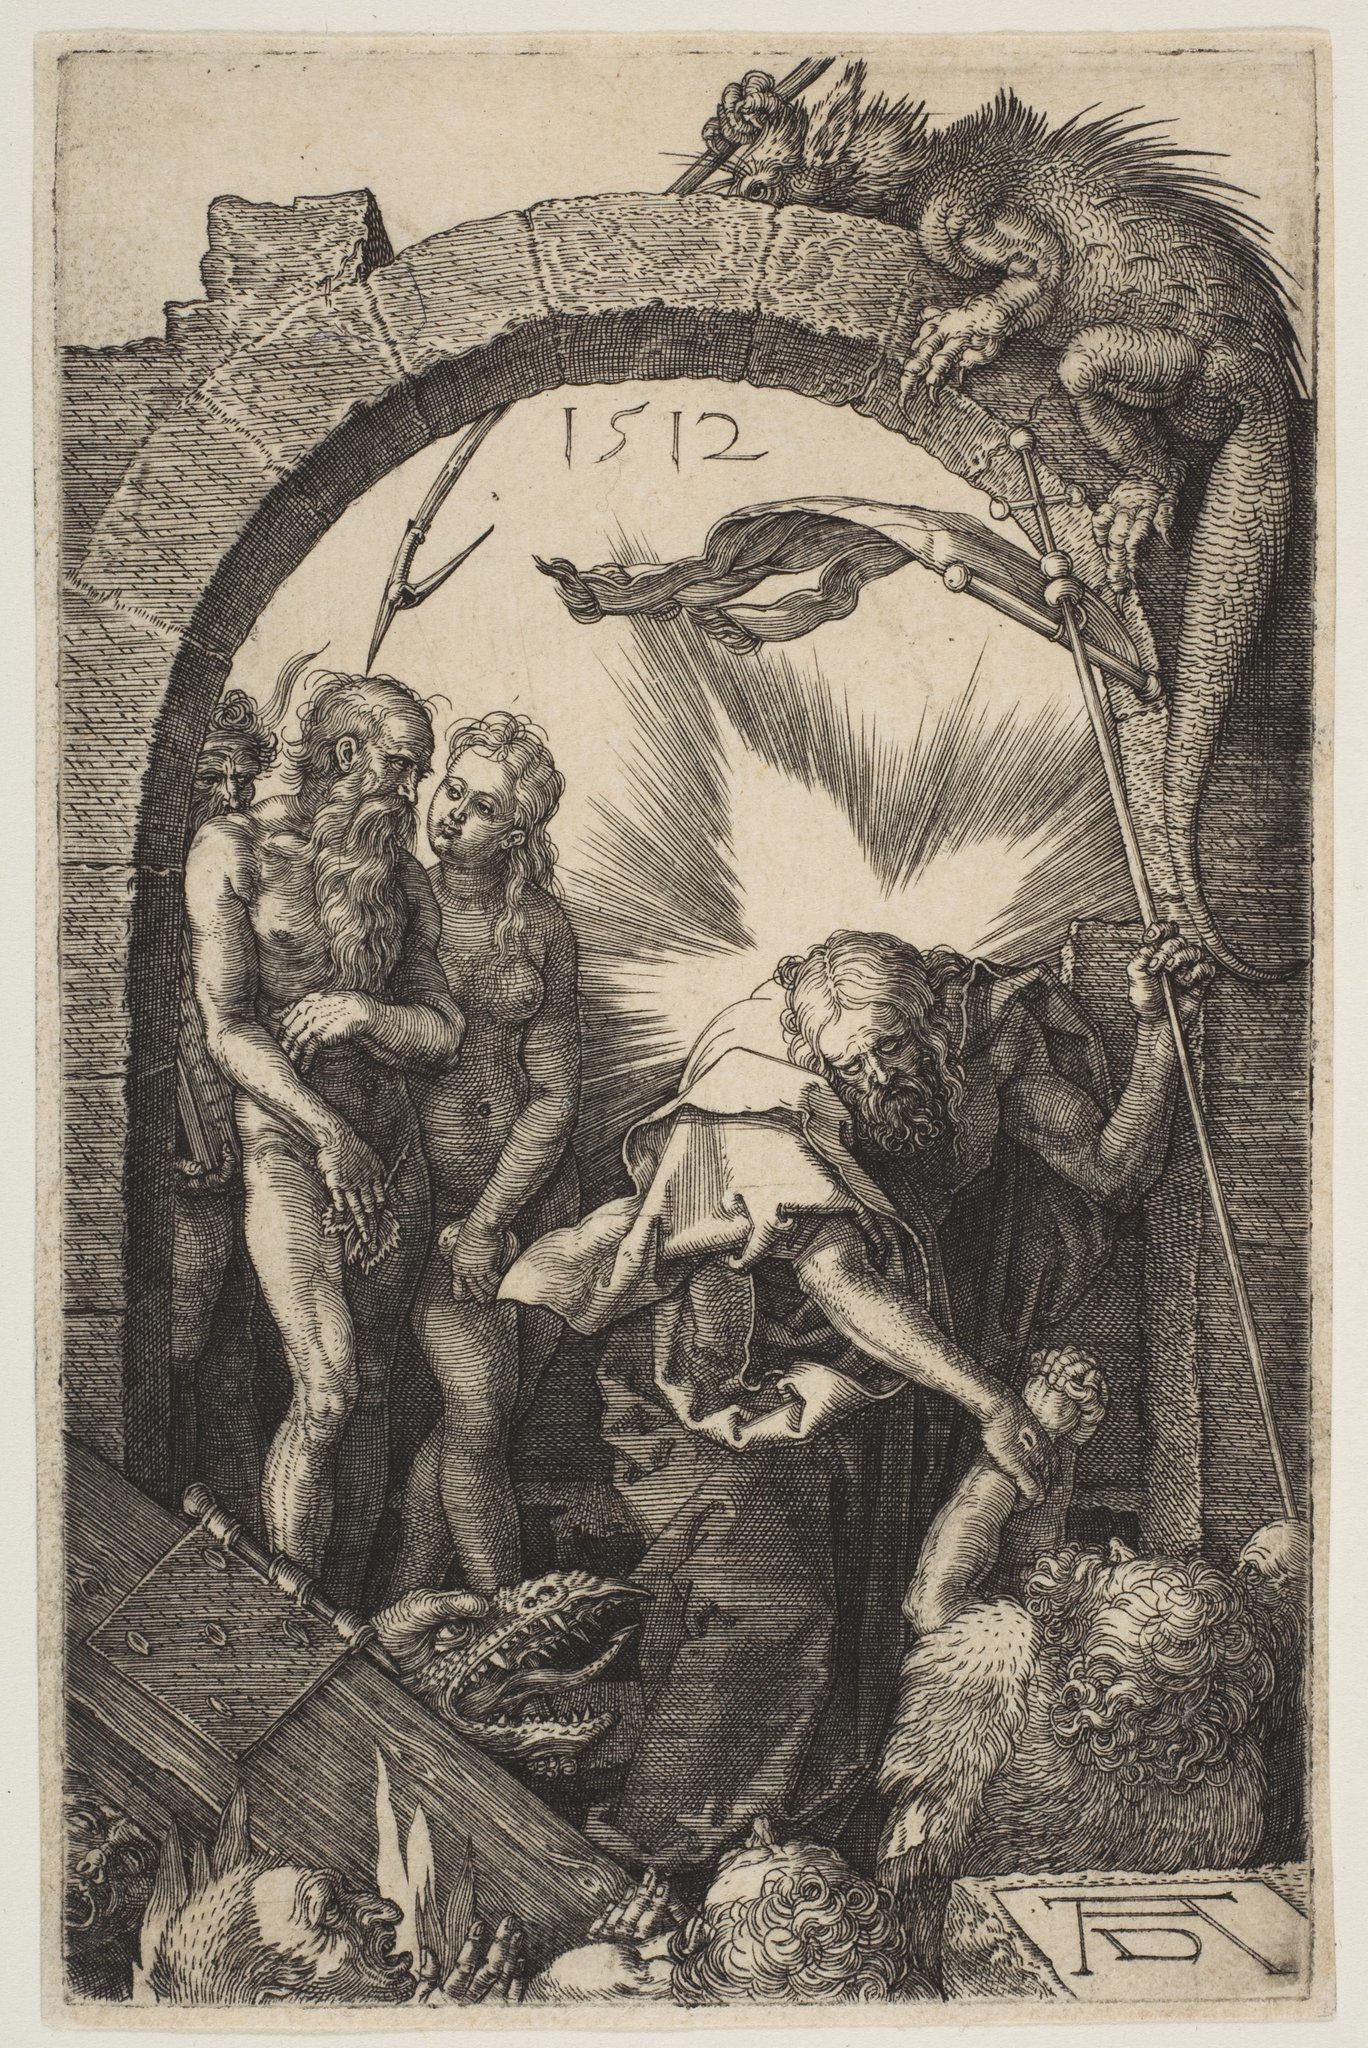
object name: print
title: Christ in Limbo, from "The Passion"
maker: albrecht dürer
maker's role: artist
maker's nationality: german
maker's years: 1471-1528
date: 1512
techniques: engraving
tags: male nudes,female nudes,christ